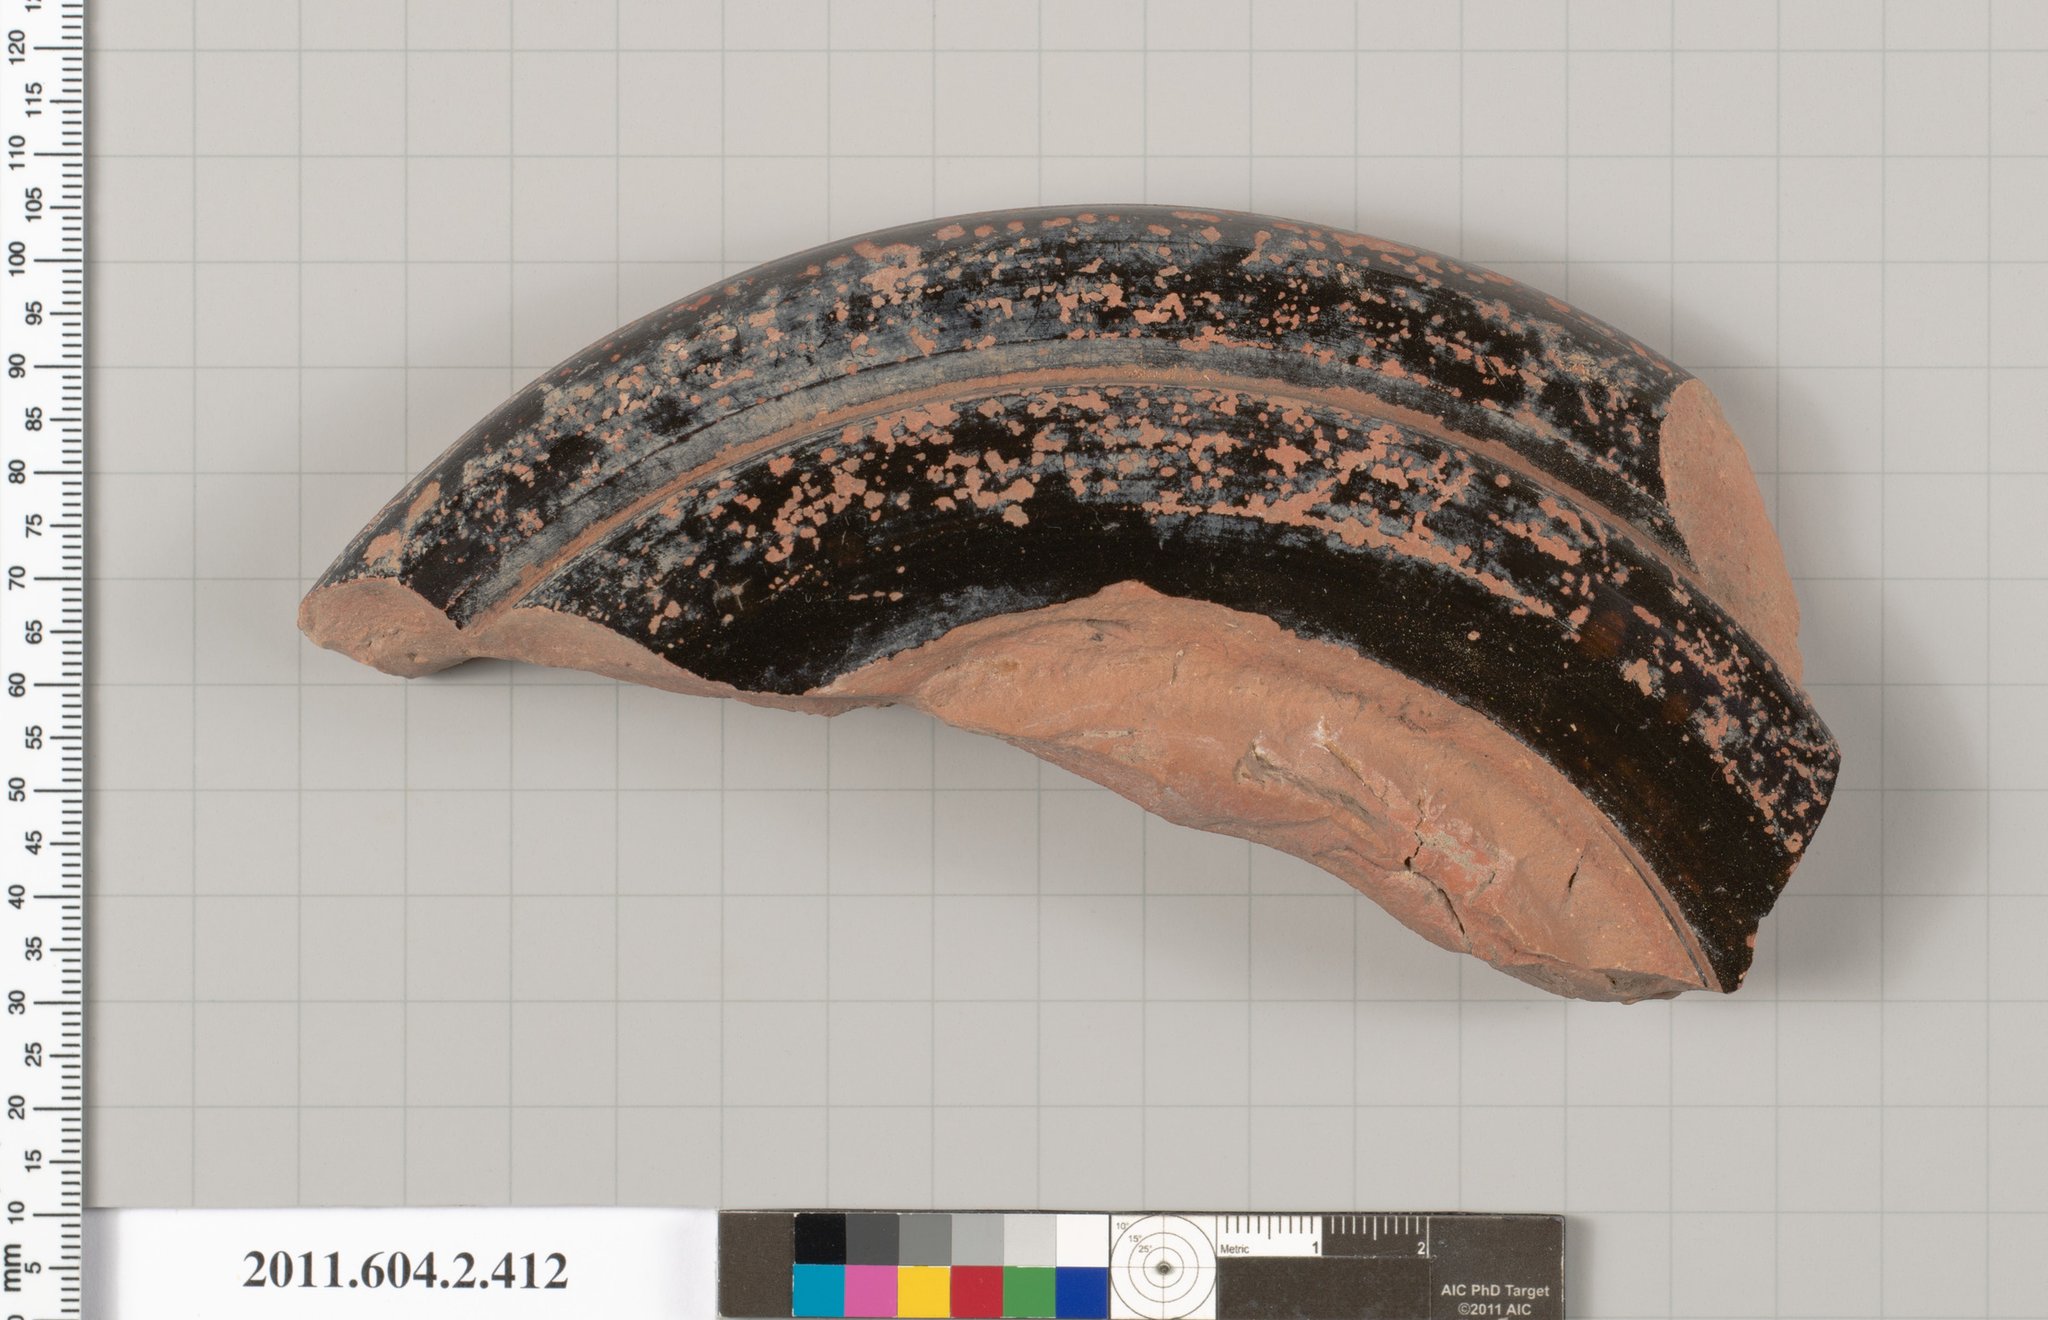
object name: column krater fragment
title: Terracotta fragment of a column-krater (bowl for mixing wine and water)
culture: greek, attic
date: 475-451 BCE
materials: terracotta